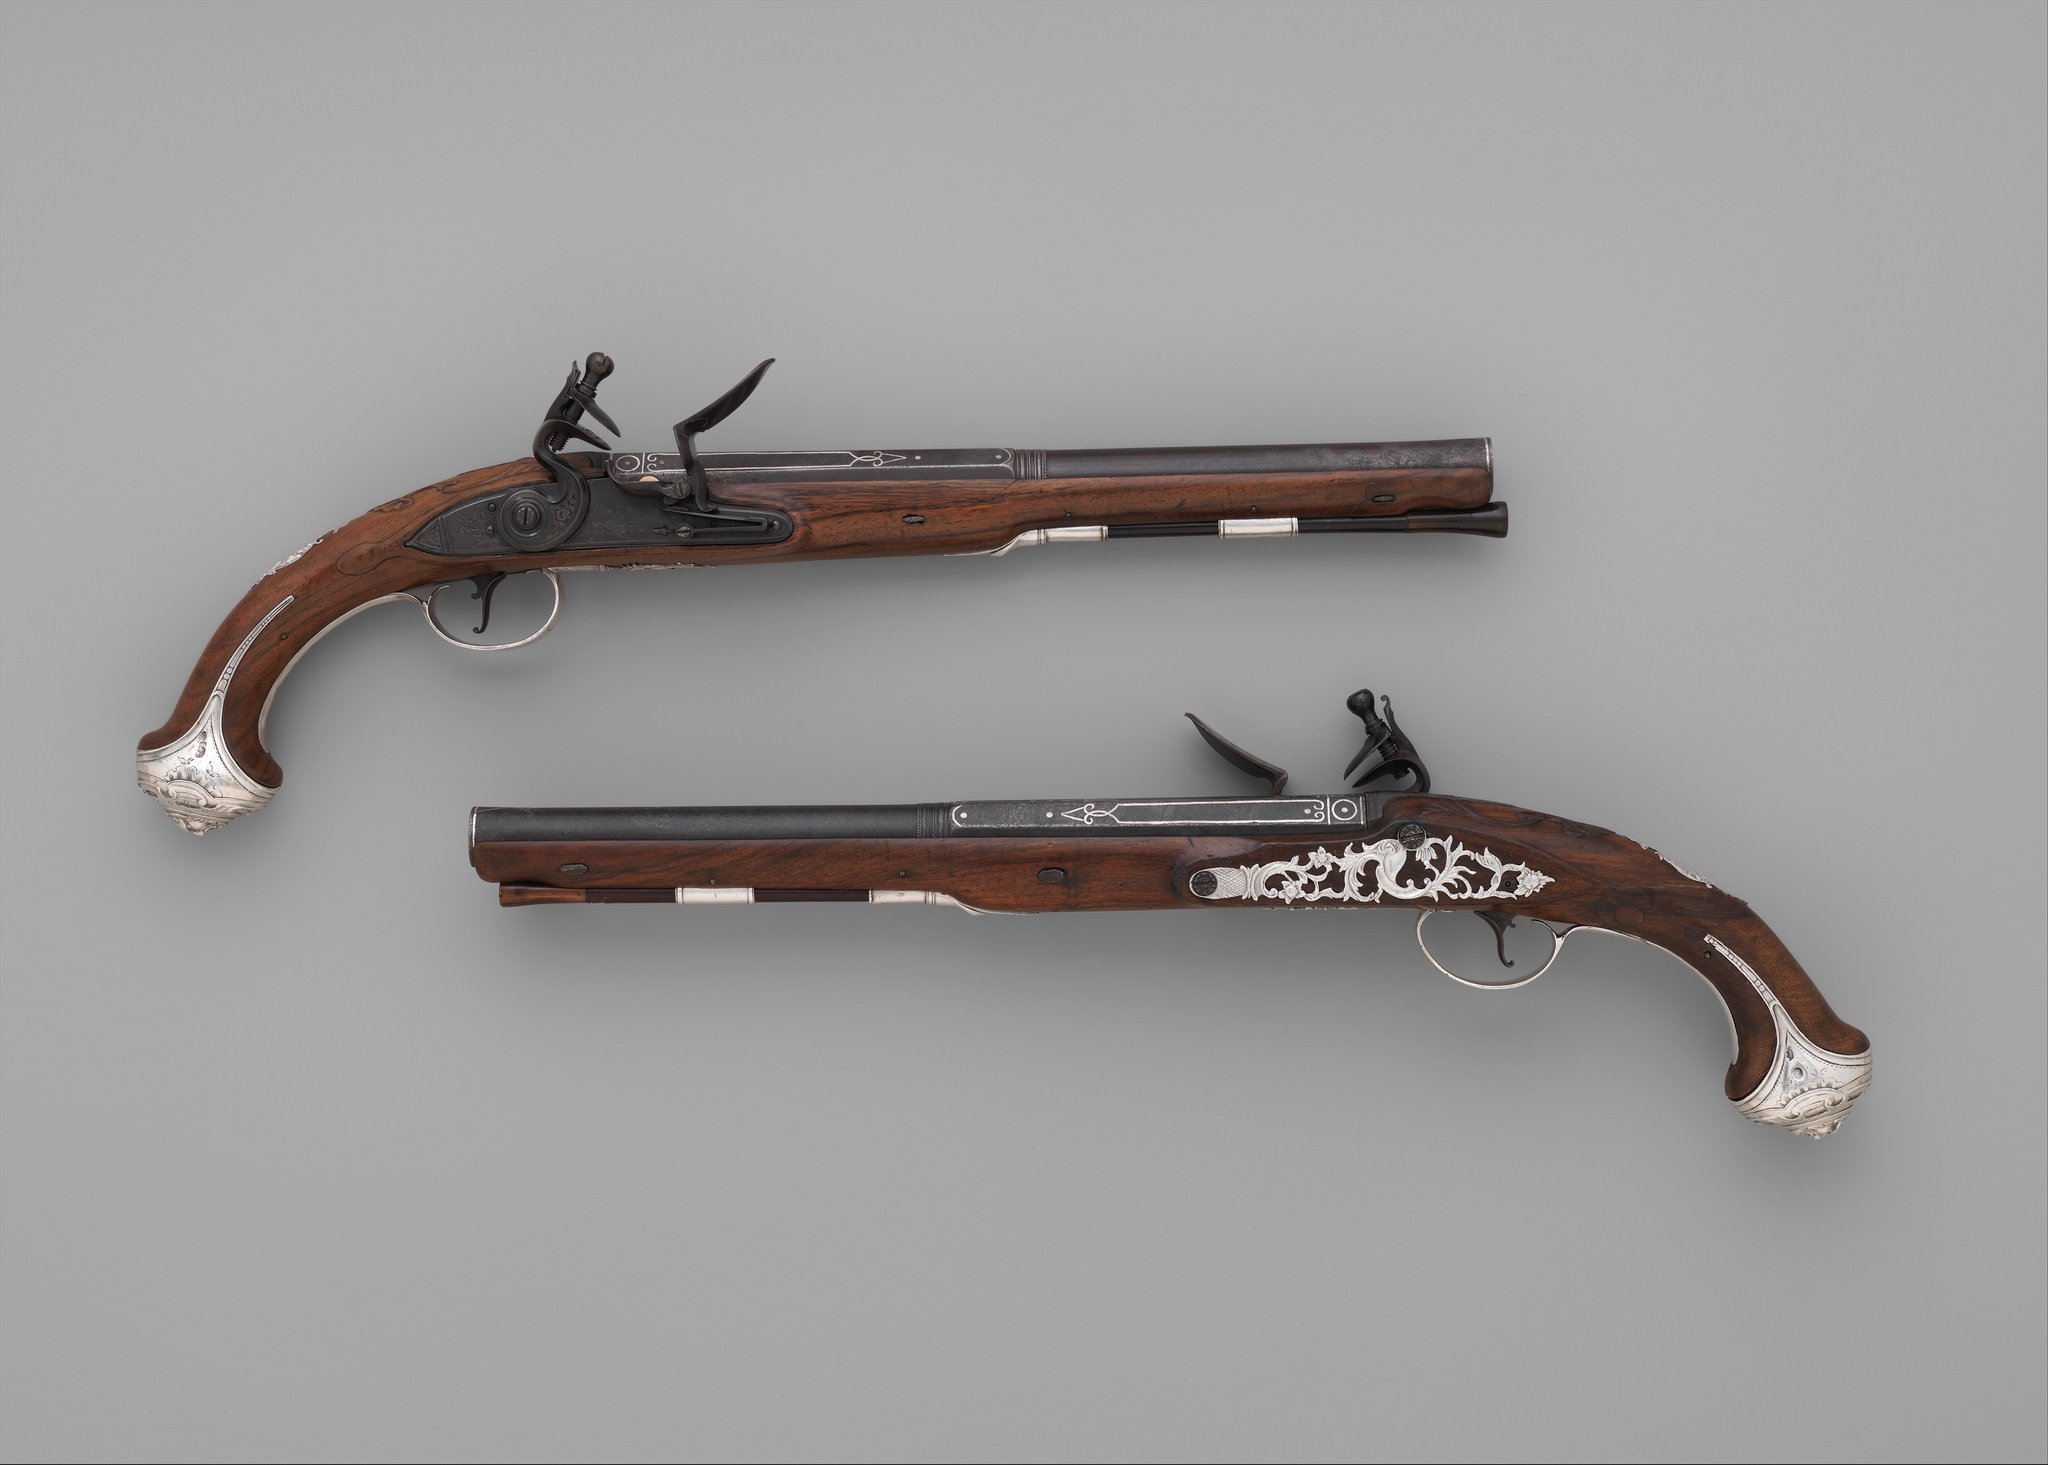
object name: pair of flintlock pistol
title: Pair of Flintlock Pistols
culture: irish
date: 1775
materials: horn, silver, steel, wood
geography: ireland